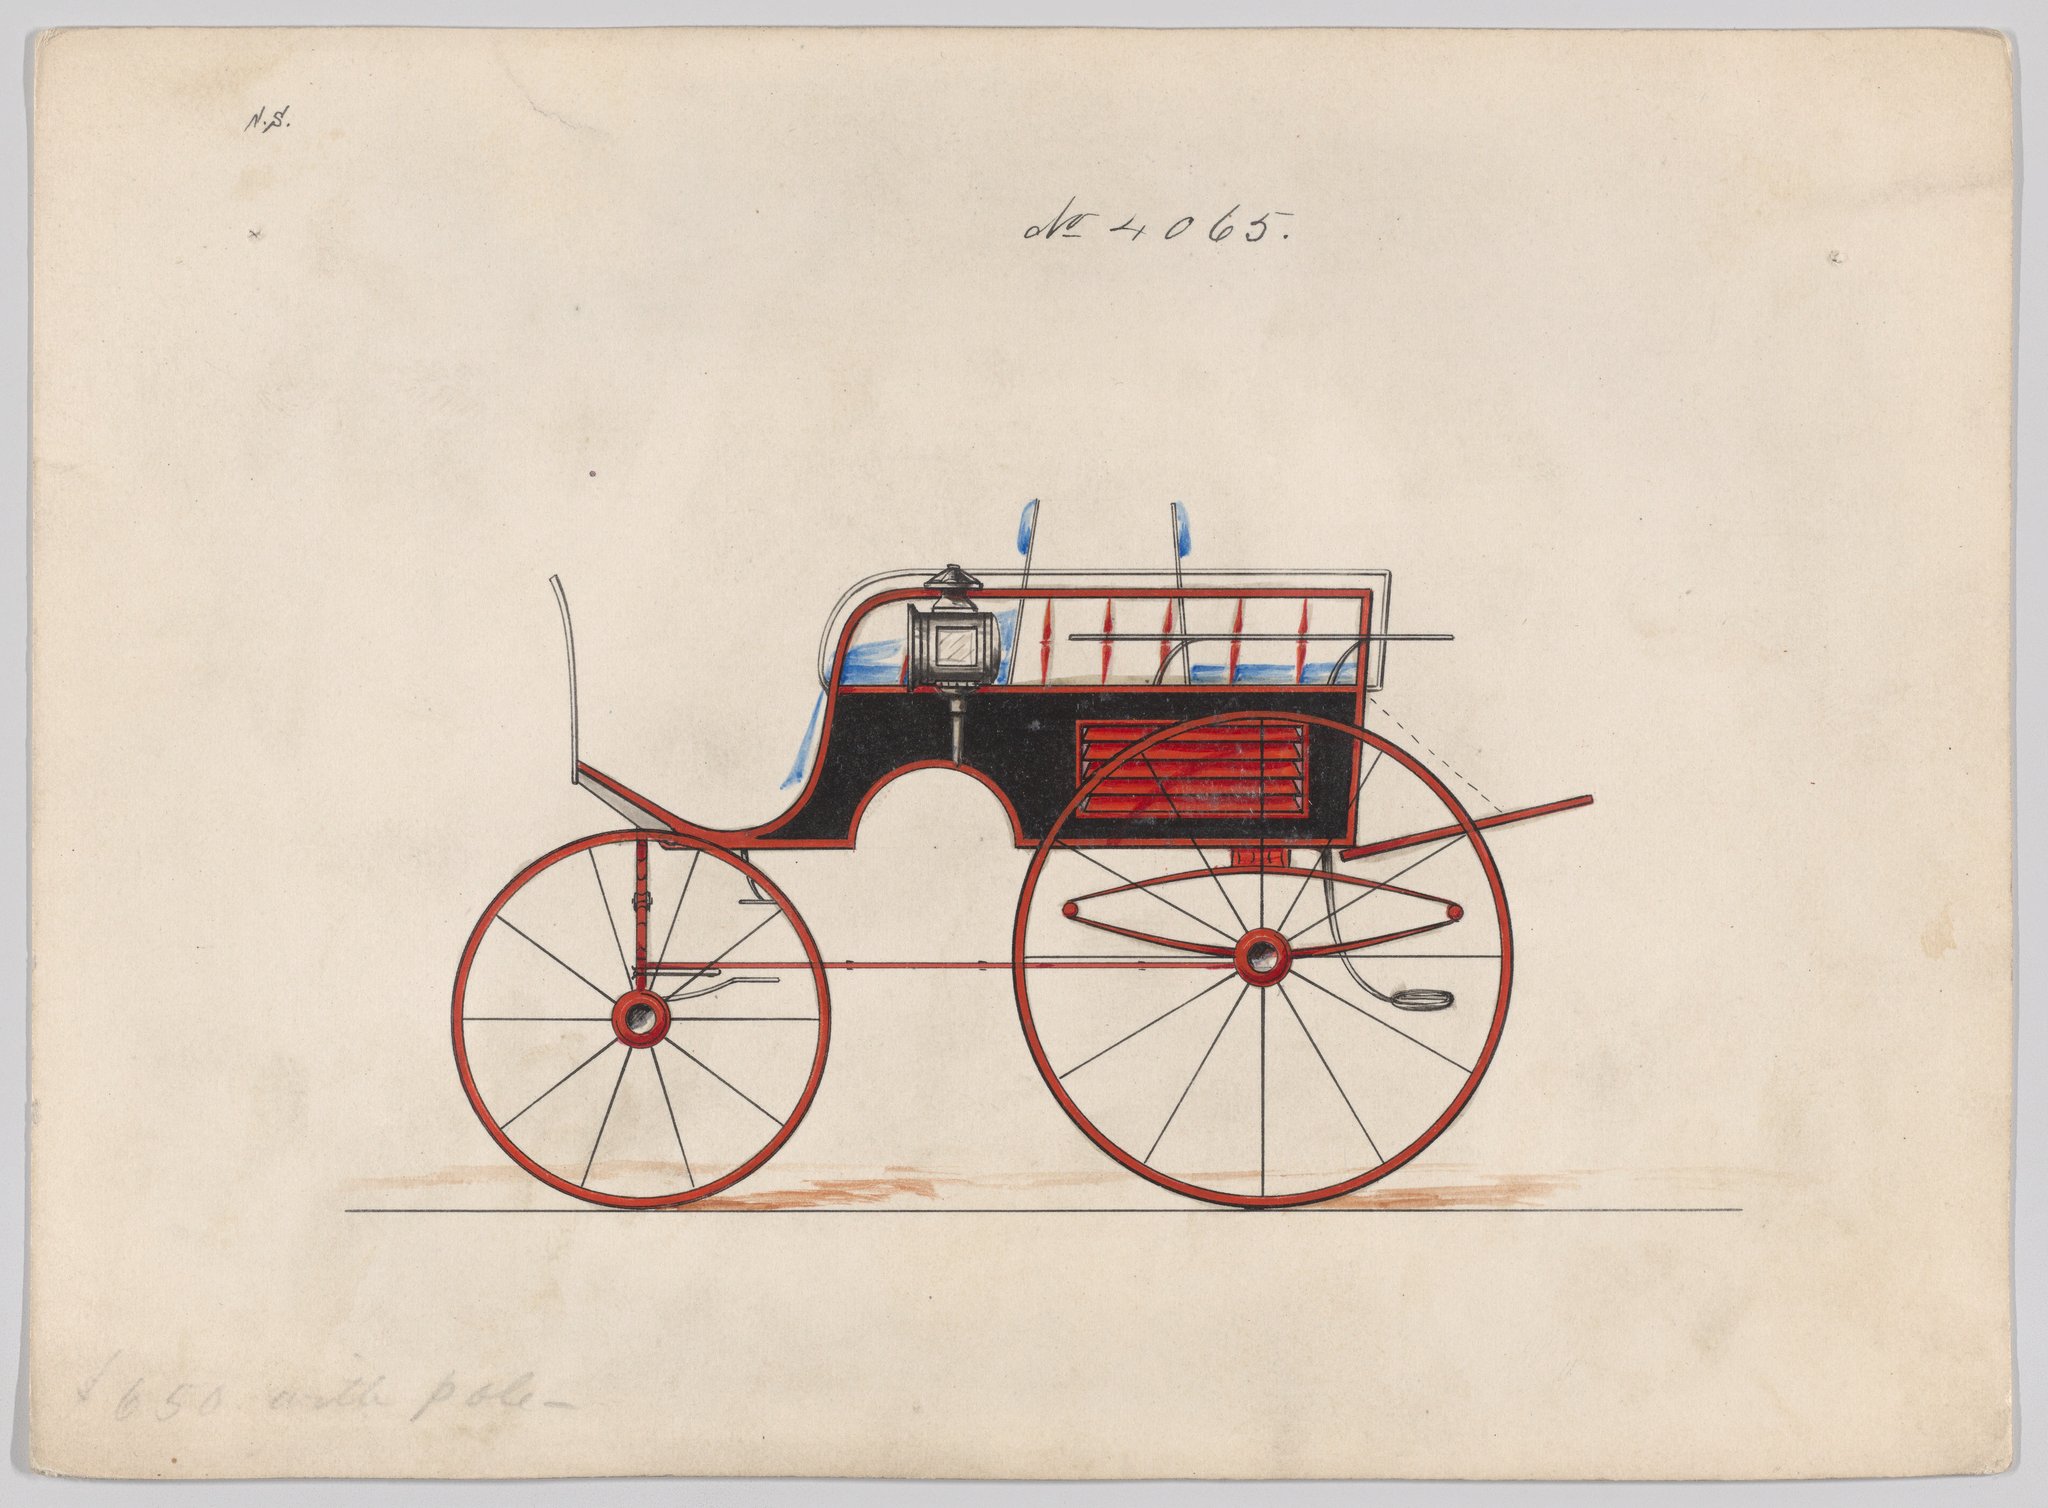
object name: drawing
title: Design for Dos-a-Dos Phaeton, no. 4065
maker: brewster & co.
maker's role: manufacturer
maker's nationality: american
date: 1890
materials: gouache, gum arabic, ink, watercolor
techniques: pen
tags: carriages